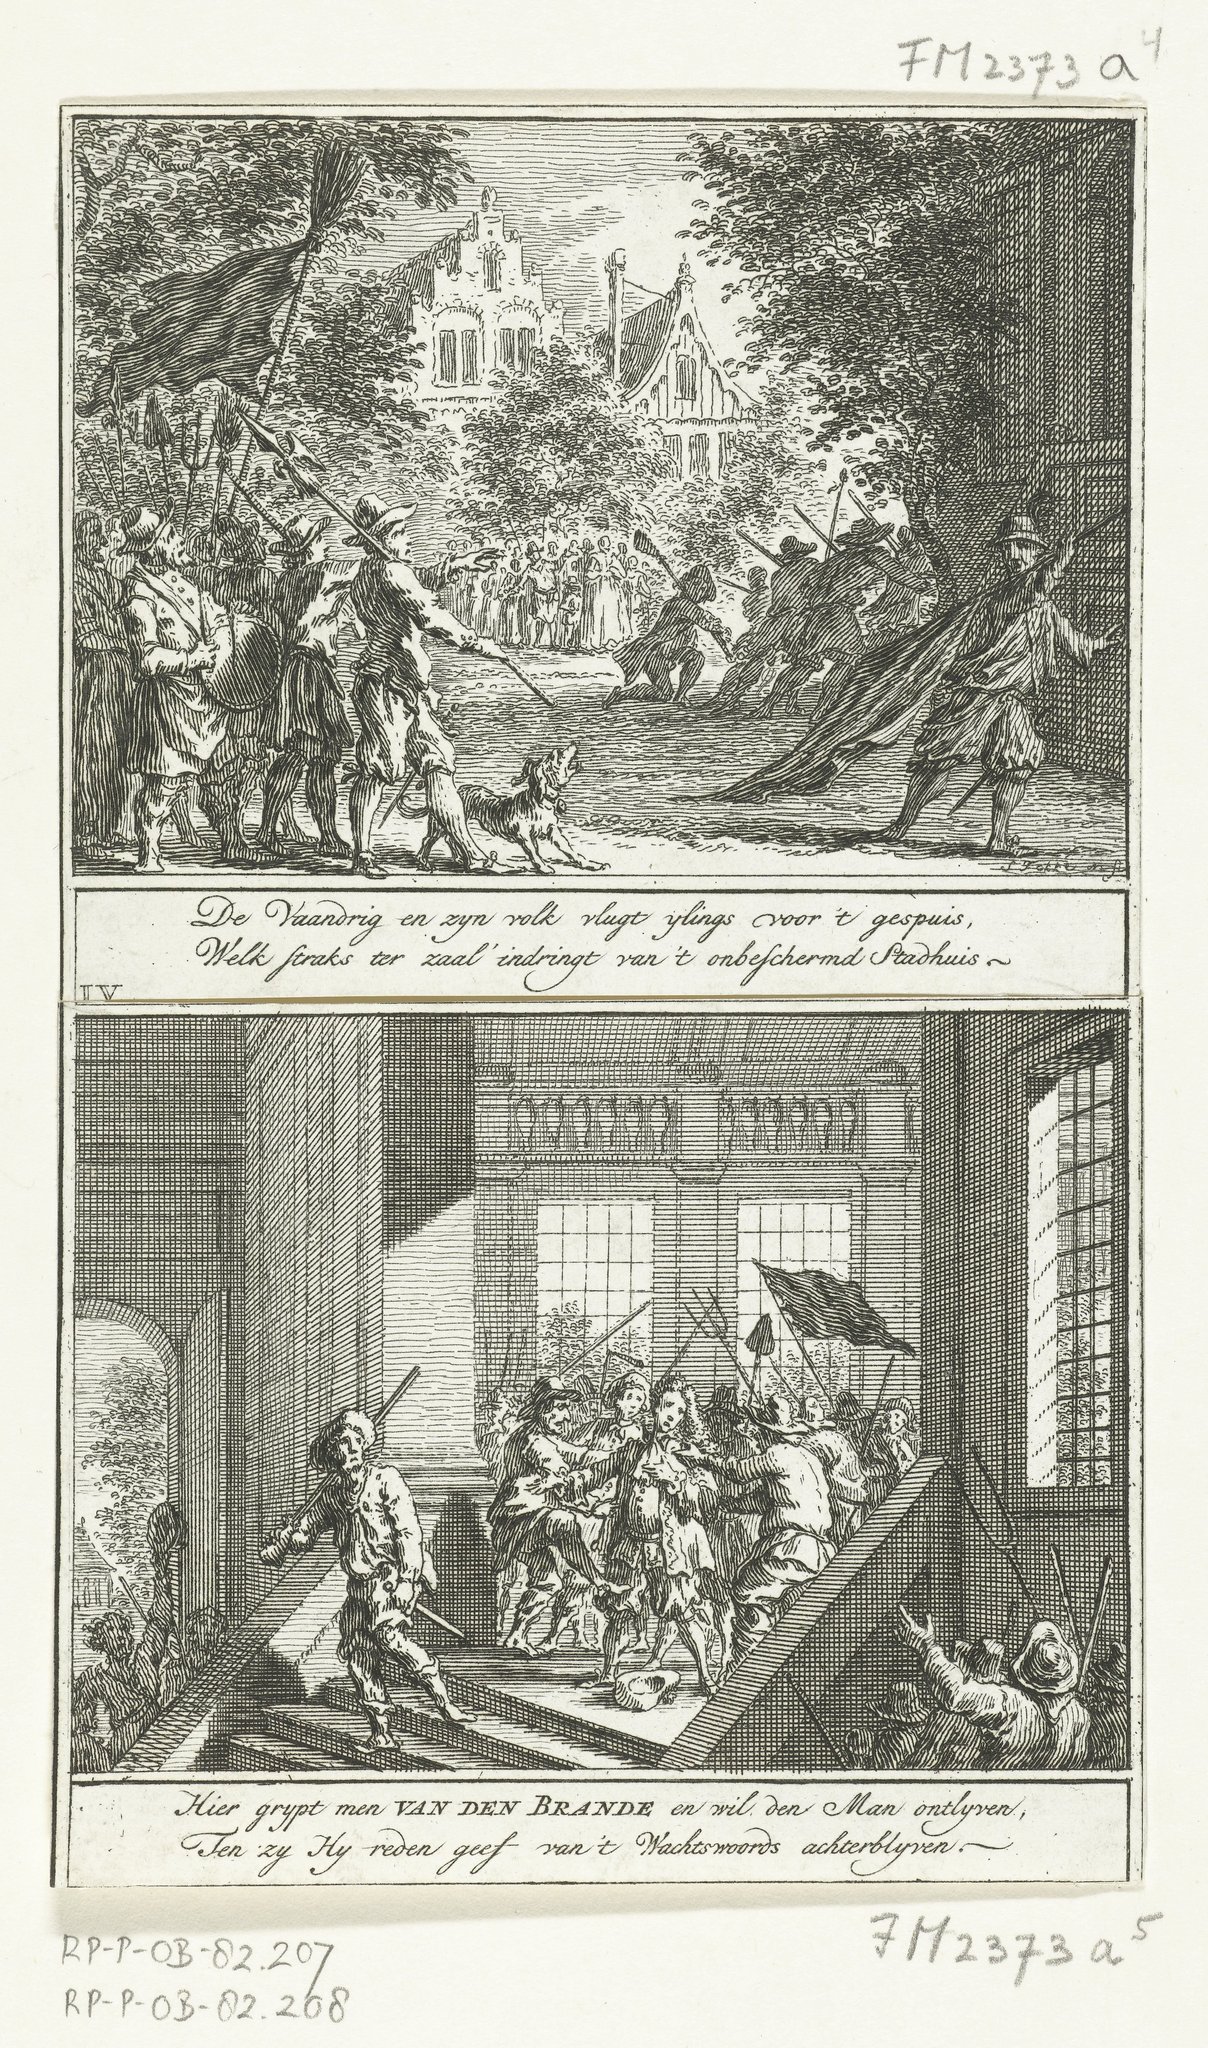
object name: print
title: Mishandeling van burgemeester Van den Brande, 1672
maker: simon fokke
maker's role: draughtsman, print maker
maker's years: 1712-1784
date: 1764-1766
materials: paper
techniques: etching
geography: northern netherlands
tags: mayor, middelburg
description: Mishandeling van burgemeester Van den Brande door de opstandige boeren, 1672. Met onderschrift van twee regels. Illustratie nr. V bij een gedicht van Petrus Johannes Beronicius over de opstandige Zeeuwse boeren en het tumult te Middelburg rond burgemeester Filips van den Brande op 21 juli 1672.